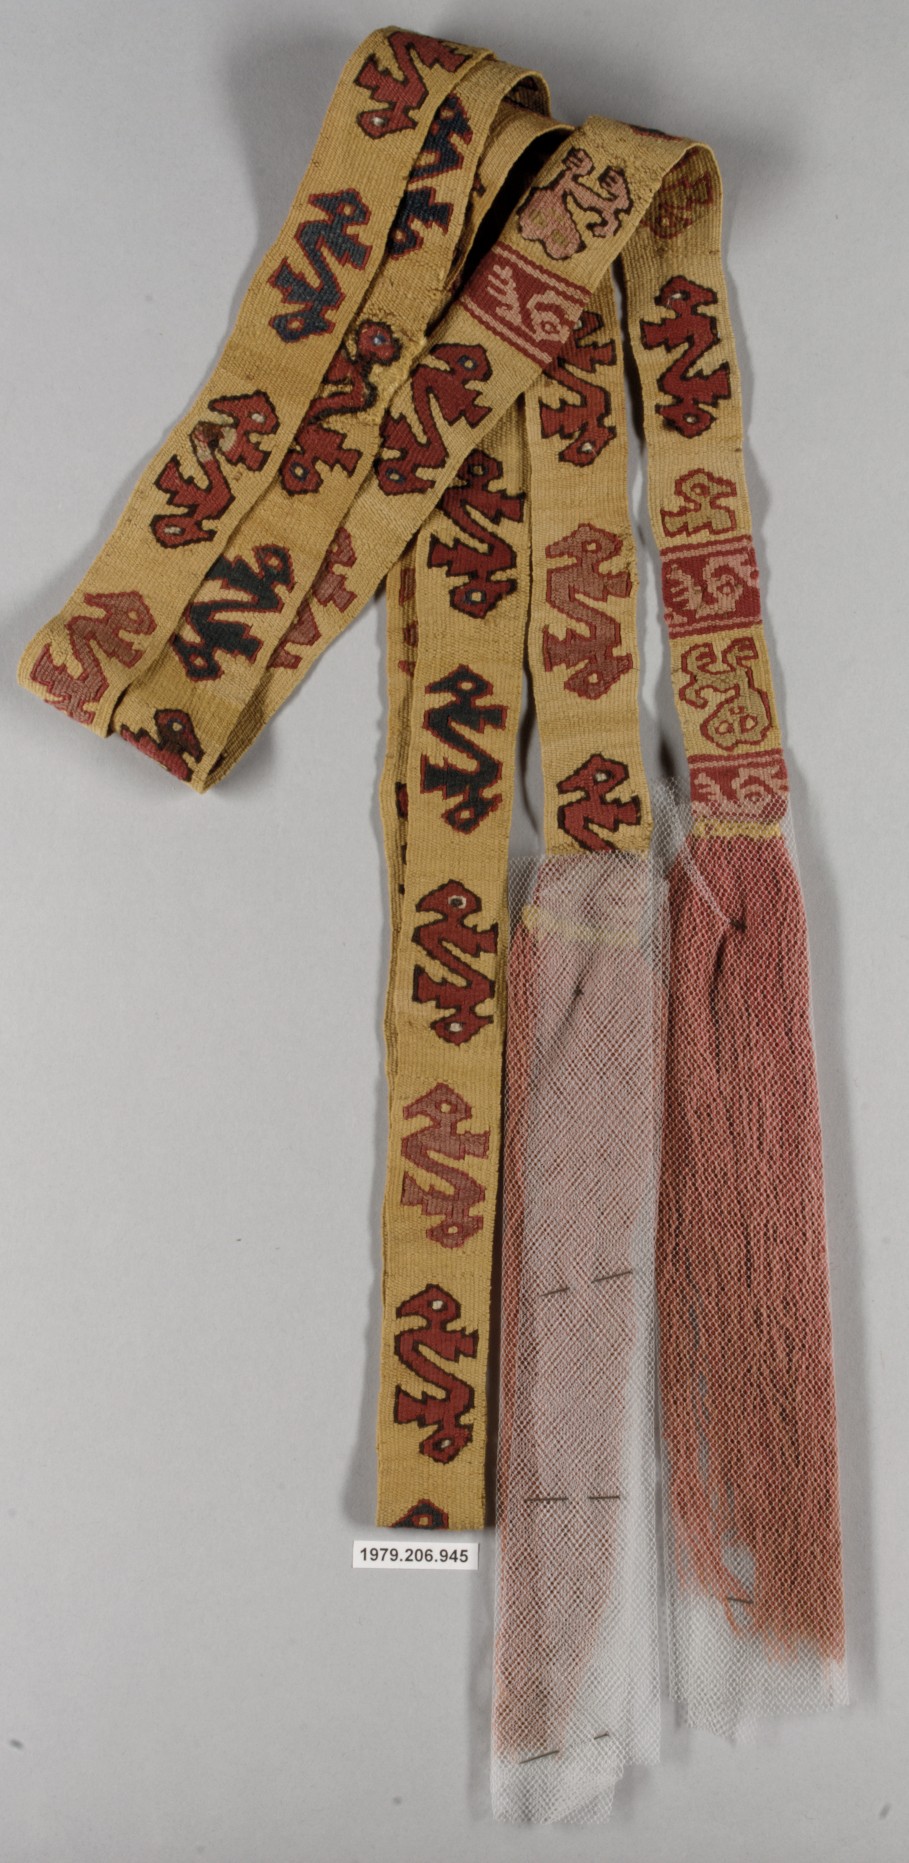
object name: sash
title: Tapestry Sash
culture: chancay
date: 1101-1400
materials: animal fiber, cotton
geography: peru